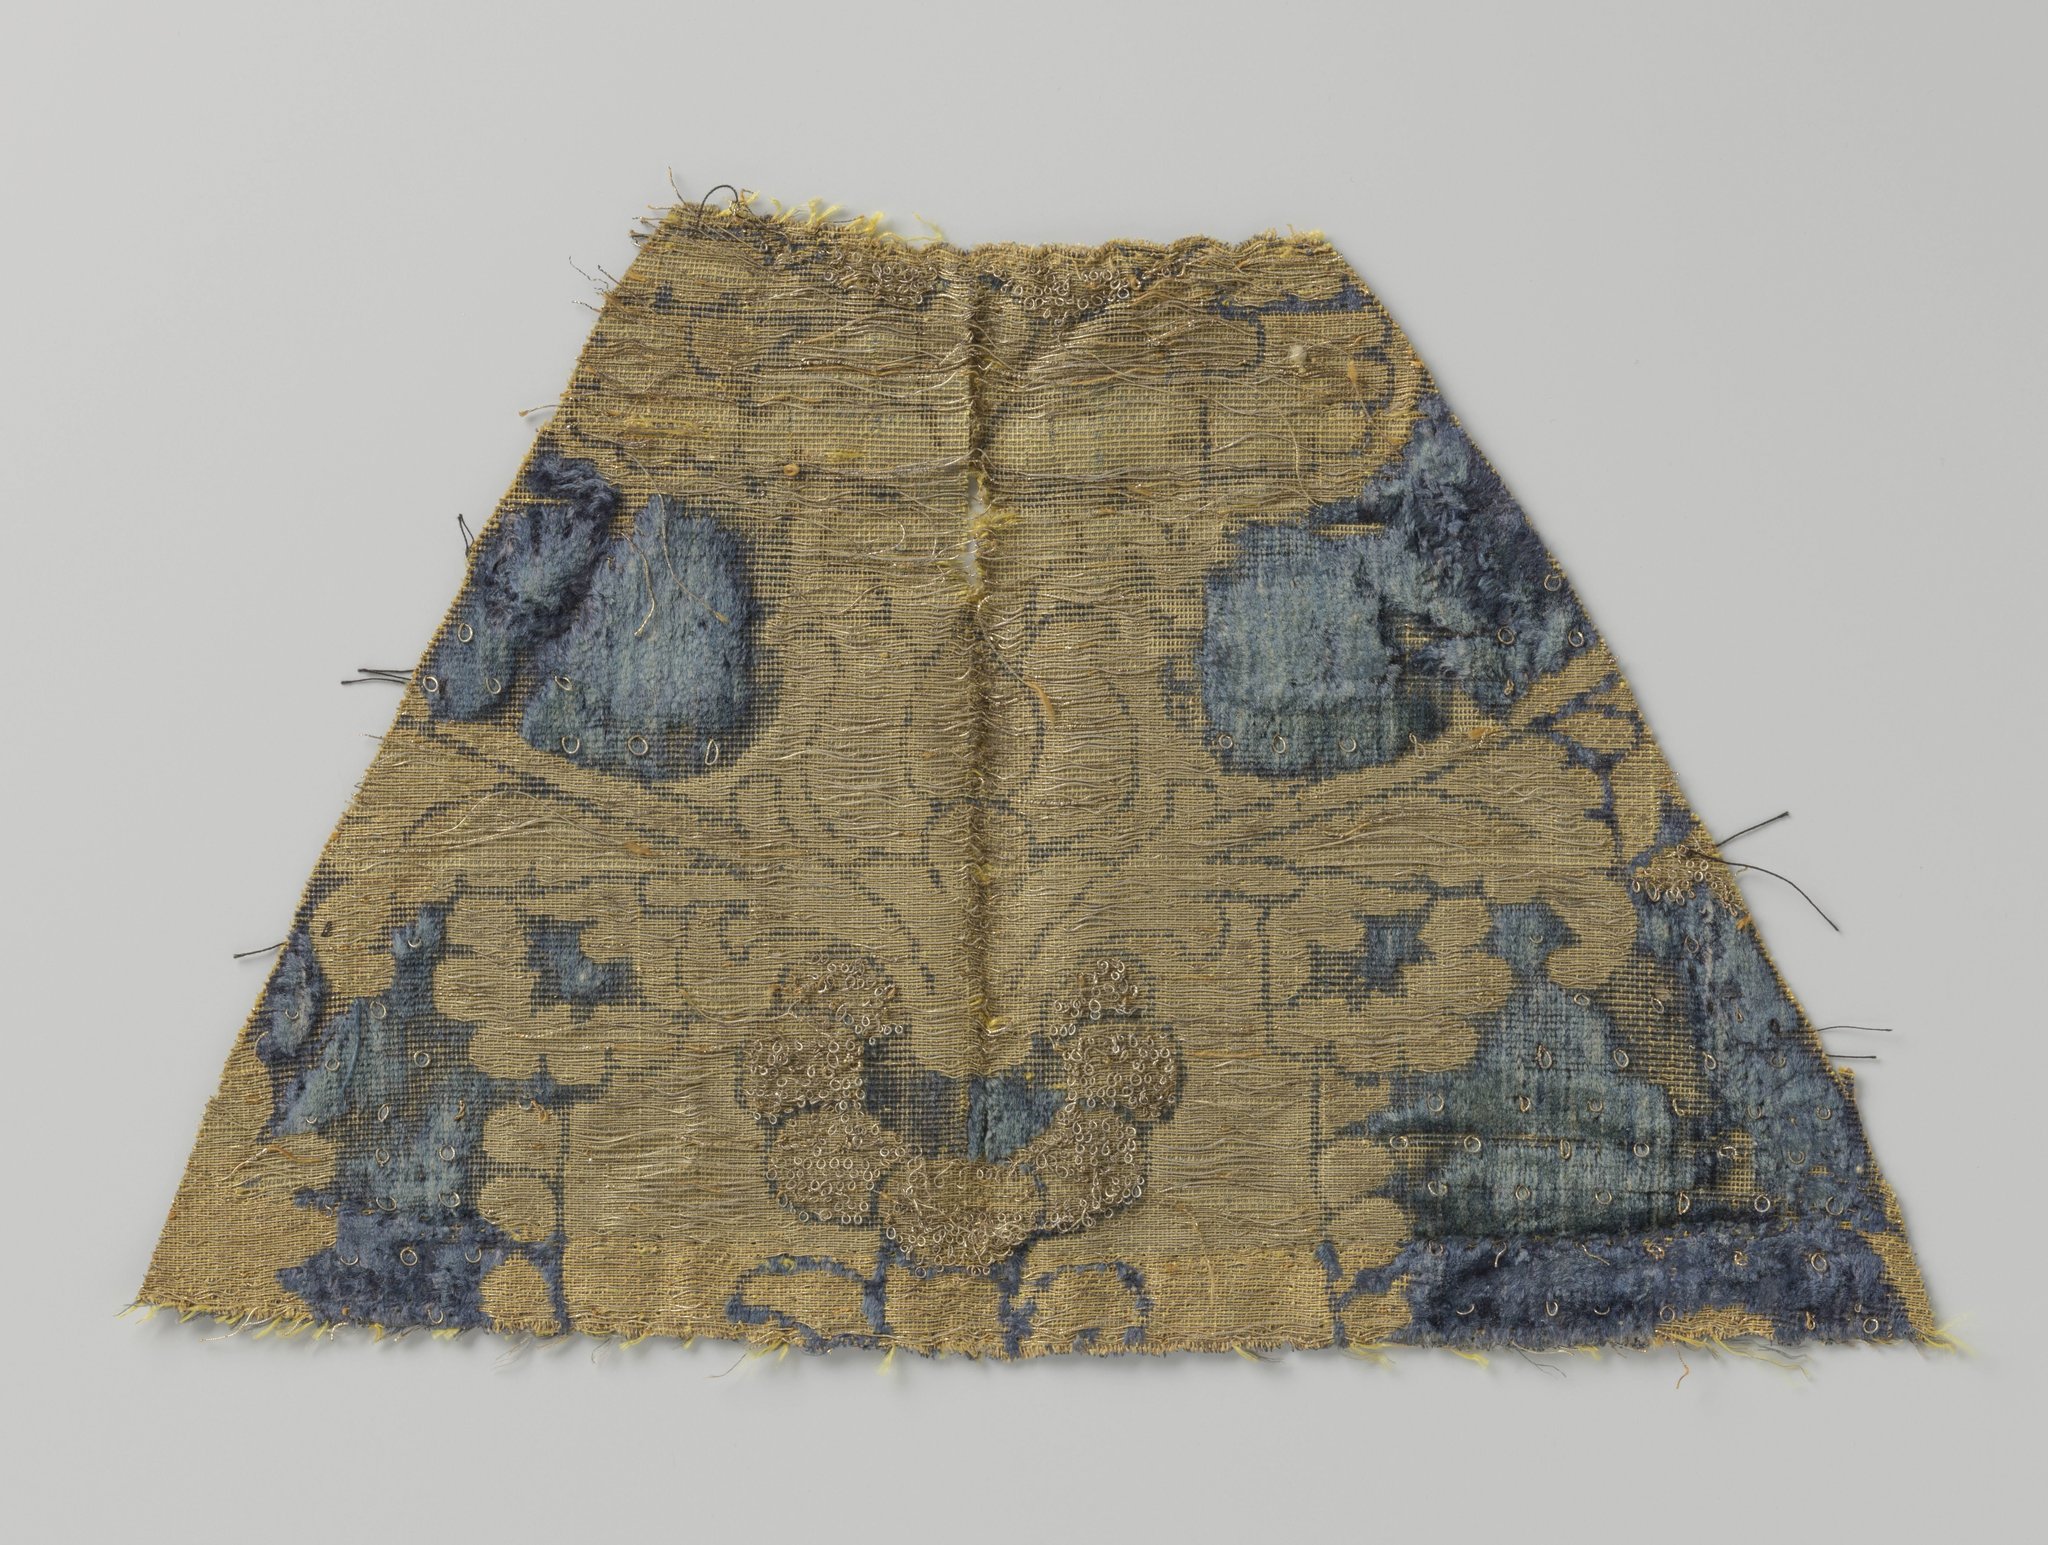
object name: brokaatfluweel, fluweelbrokaat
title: Fragment blauw fluweelbrokaat met granaatappelmotief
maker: Anonymous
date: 1420-1499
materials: gold thread, silk, velvet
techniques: brocade, weave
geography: italy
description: Fragment blauw zijden fluweelbrokaat met granaatappelmotief.